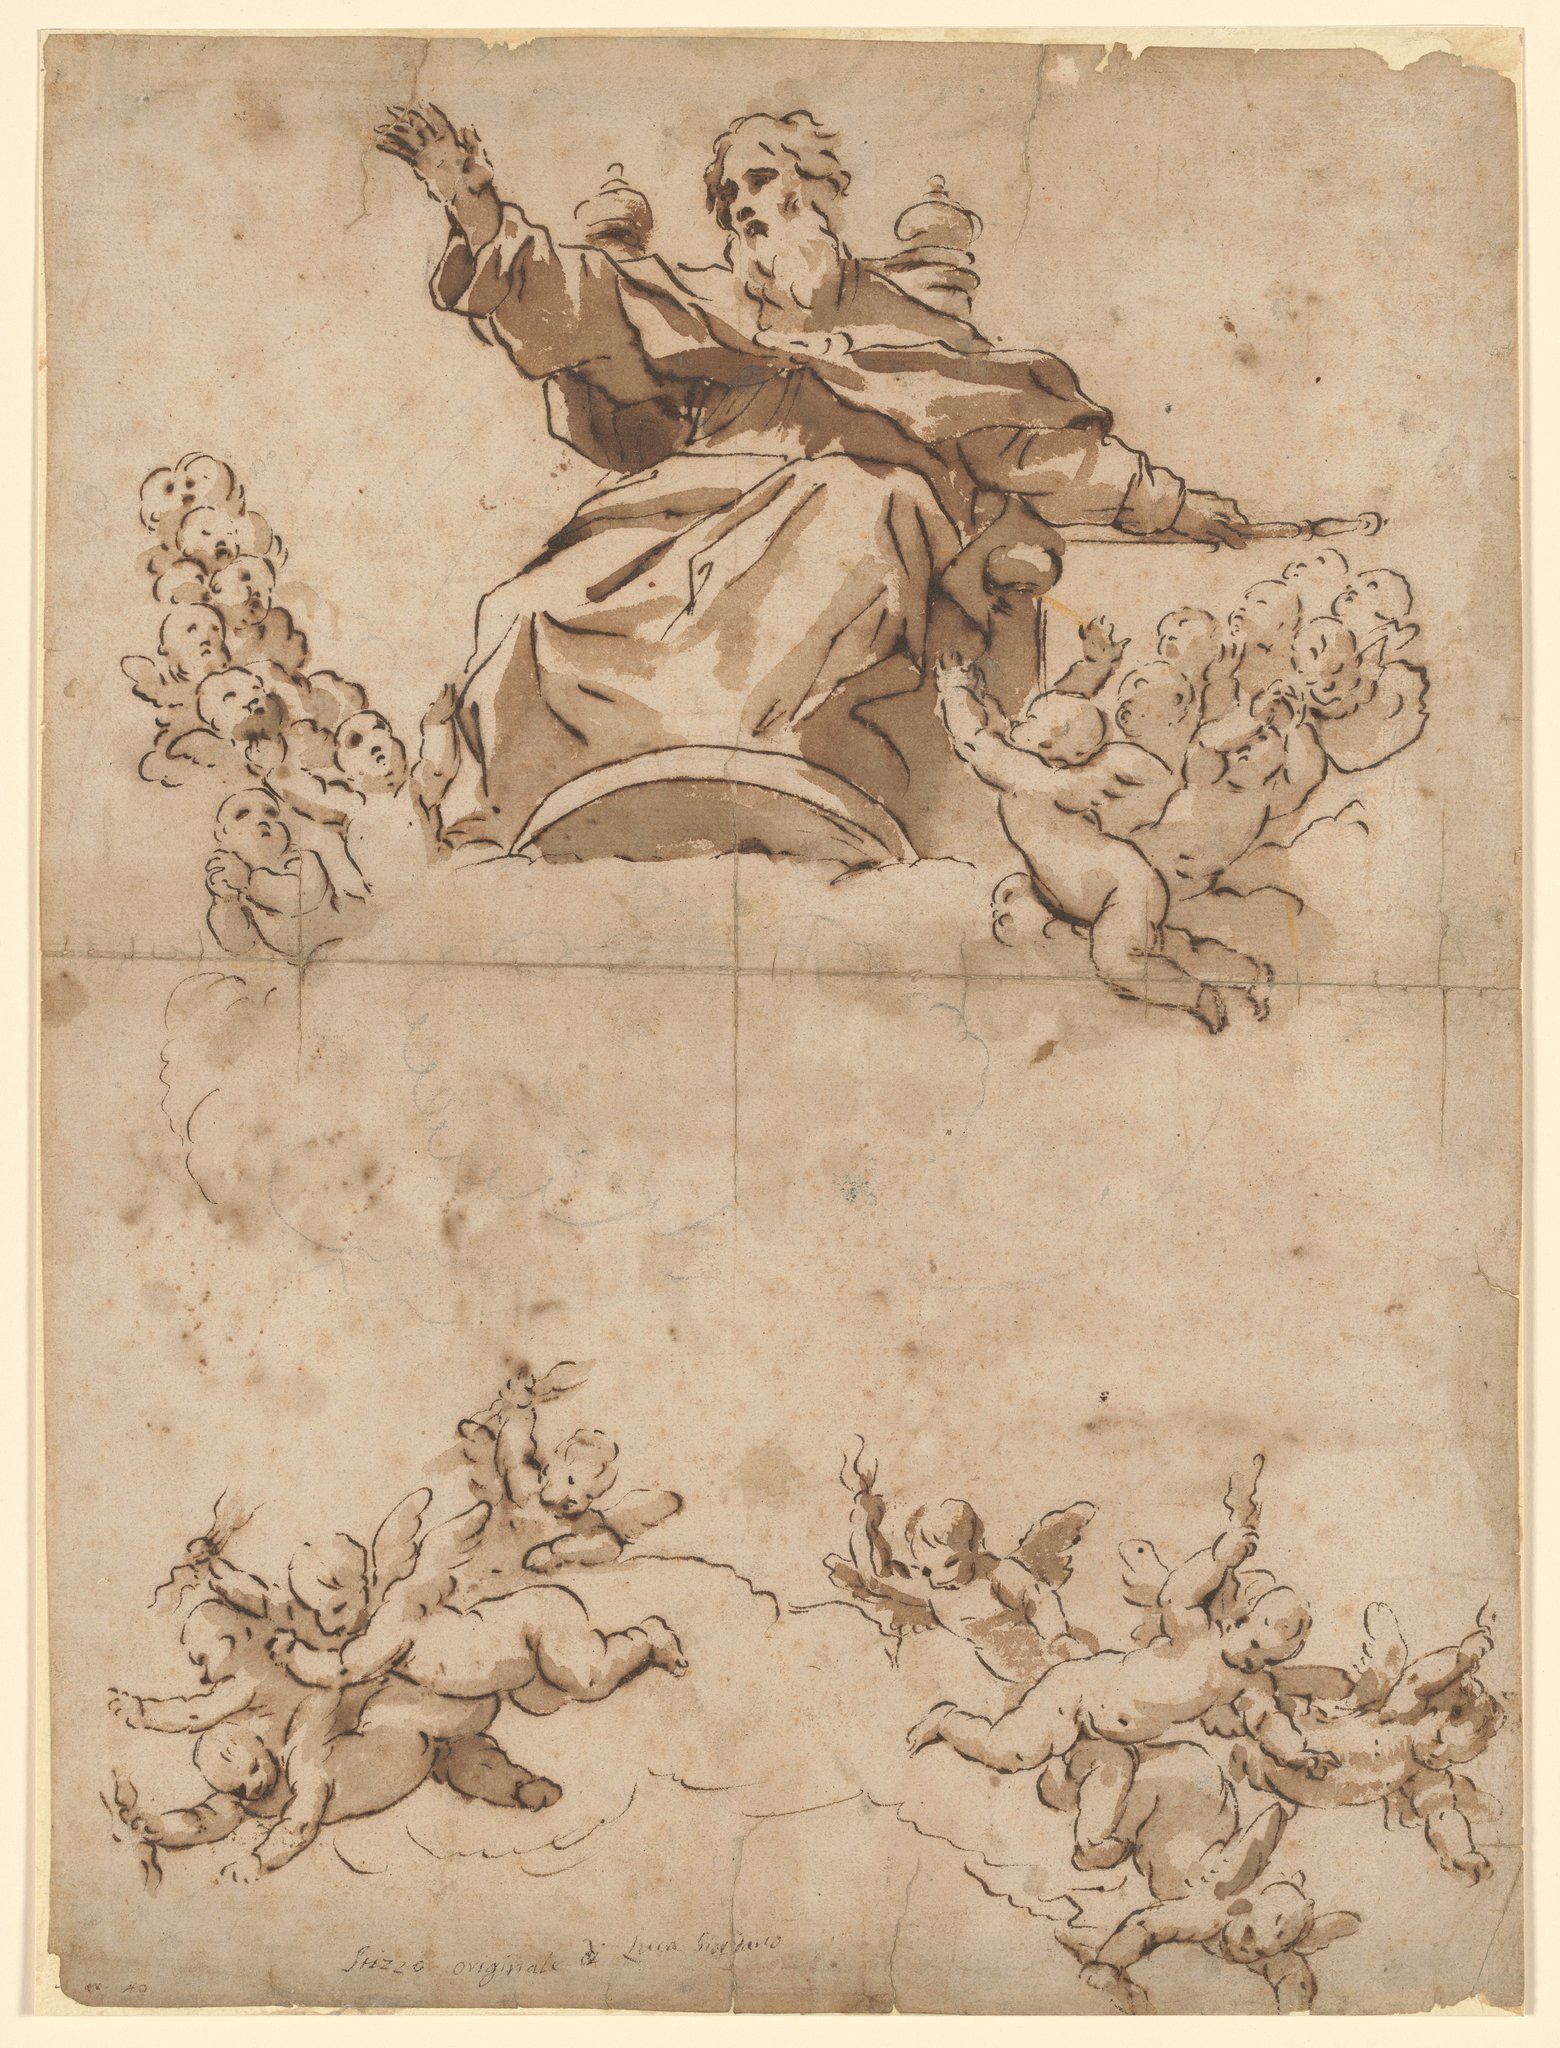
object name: drawing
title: The Almighty with Angels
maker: luca giordano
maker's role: artist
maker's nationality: italian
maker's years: 1634-1705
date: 1650-1669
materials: chalk, ink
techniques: pen, wash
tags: angels,god the father